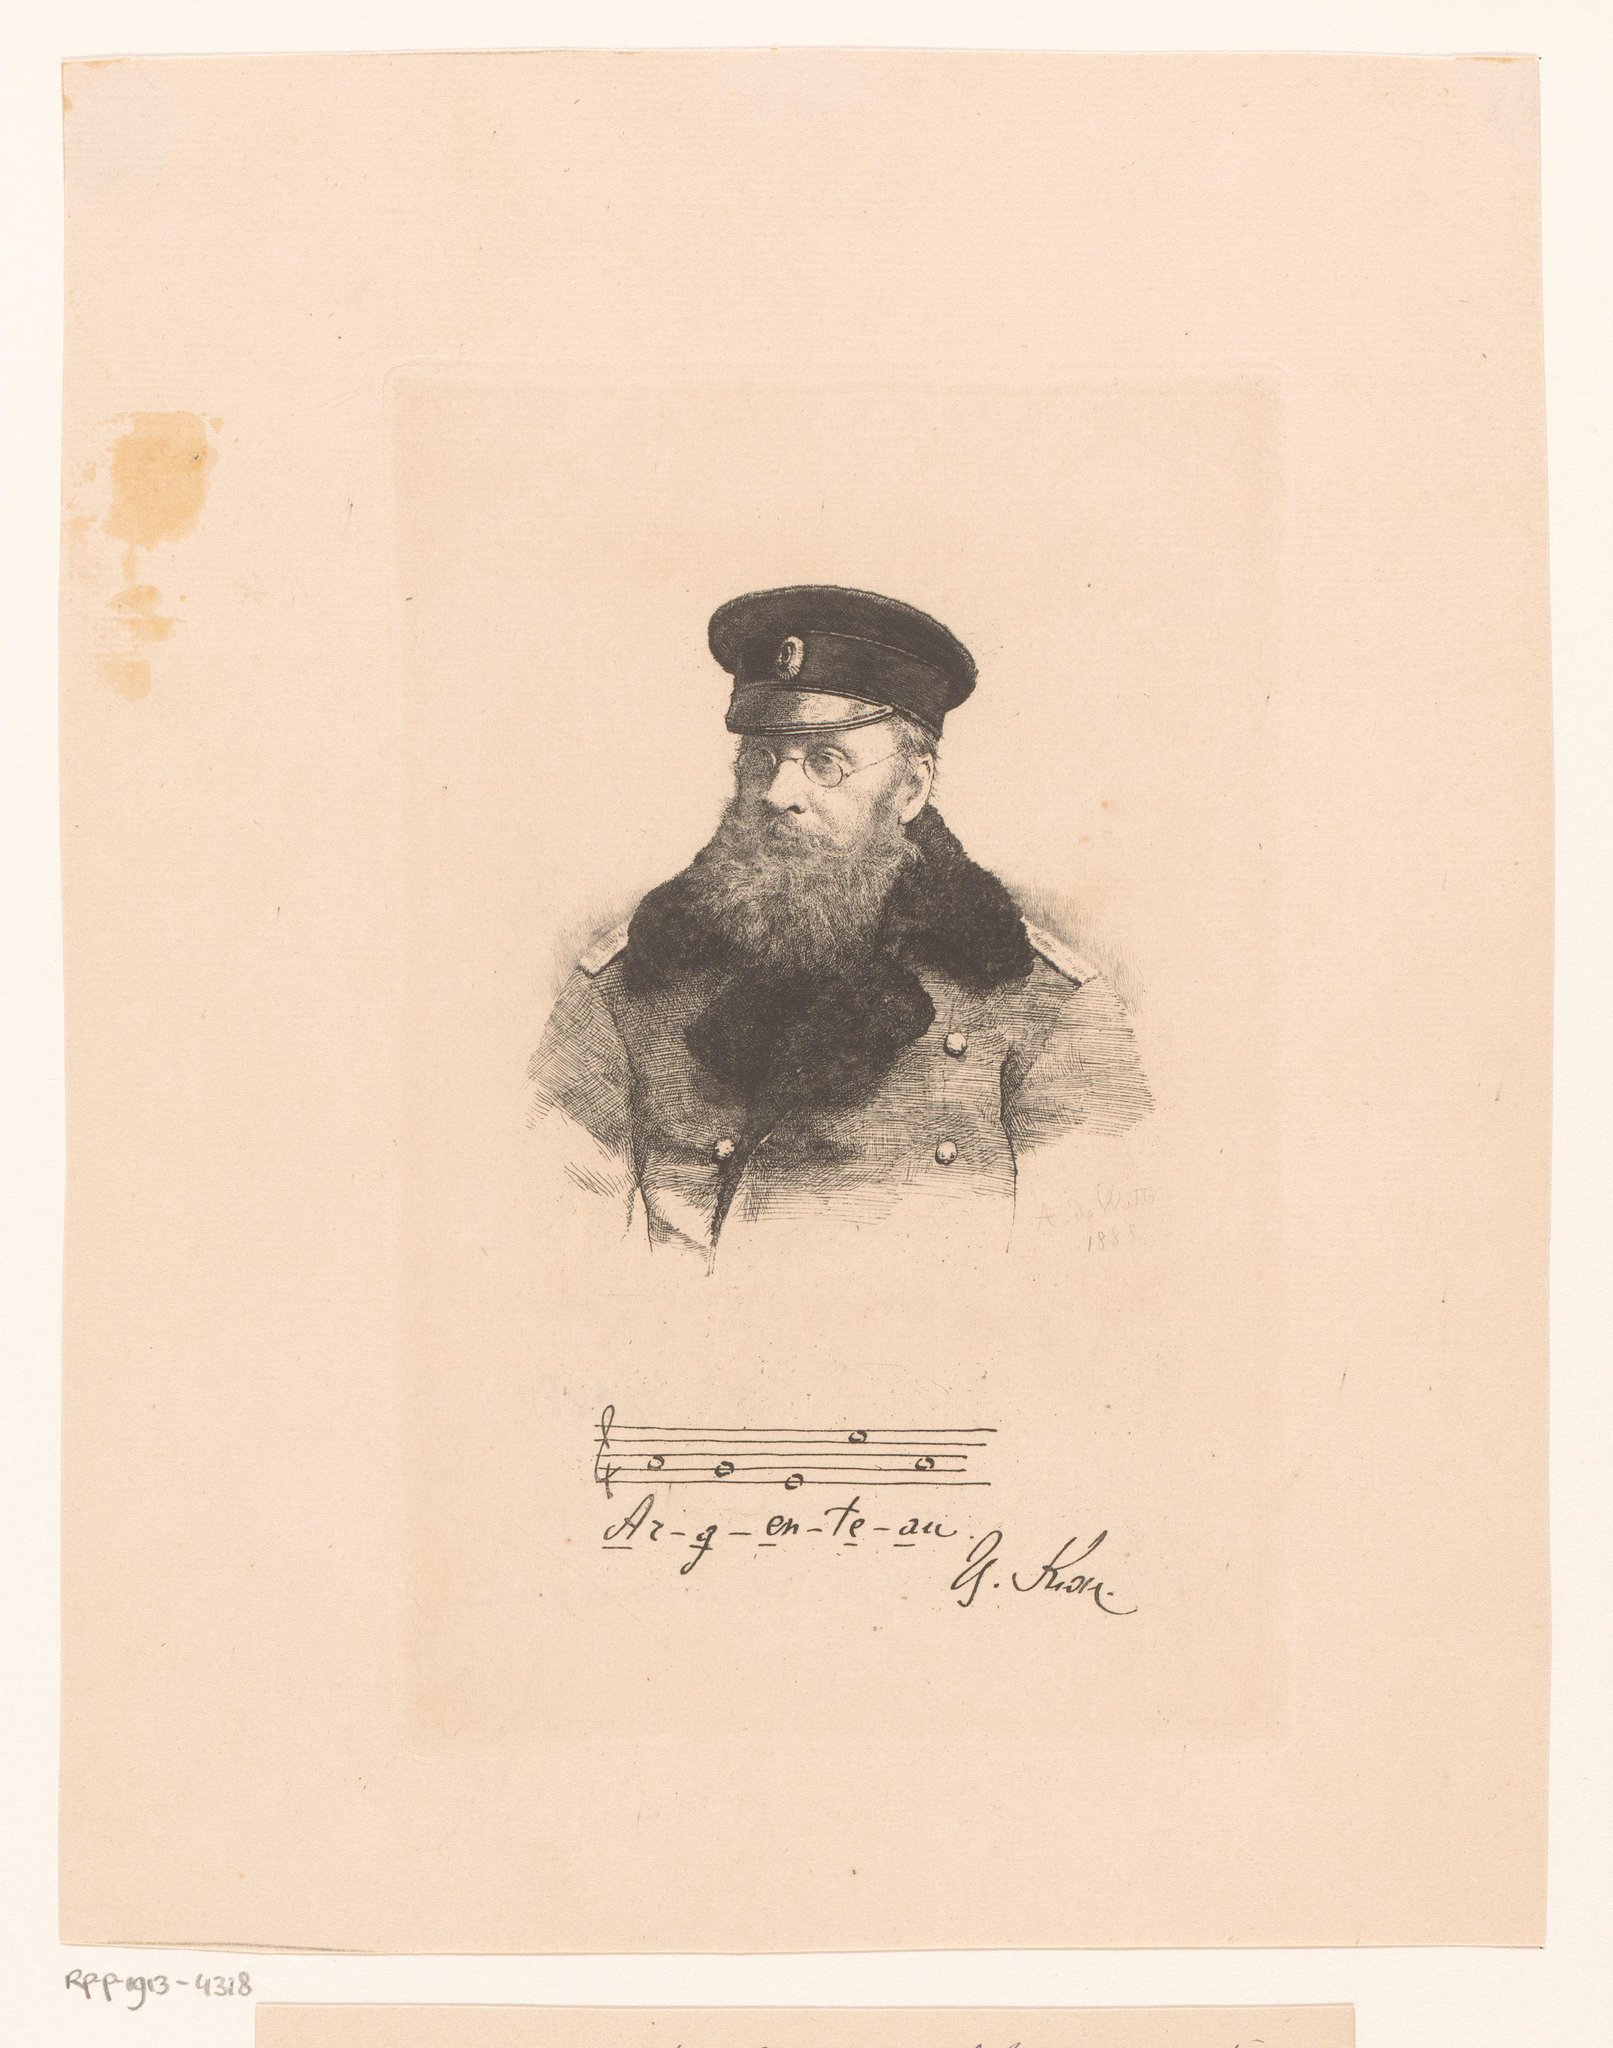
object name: print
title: Portret van César Cui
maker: adrien de witte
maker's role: print maker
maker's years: 1850-1935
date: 1888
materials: paper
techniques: etching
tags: eyeglasses, spectacles, adult man, historical persons, (military) uniforms, beard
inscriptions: collector's mark: Lugt 2228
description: Mogelijk de titelprent voor: Comtesse de Mercy-Argenteau, Louise. César Cui: esquisse critique. Parijs: Fishbacher, 1888.